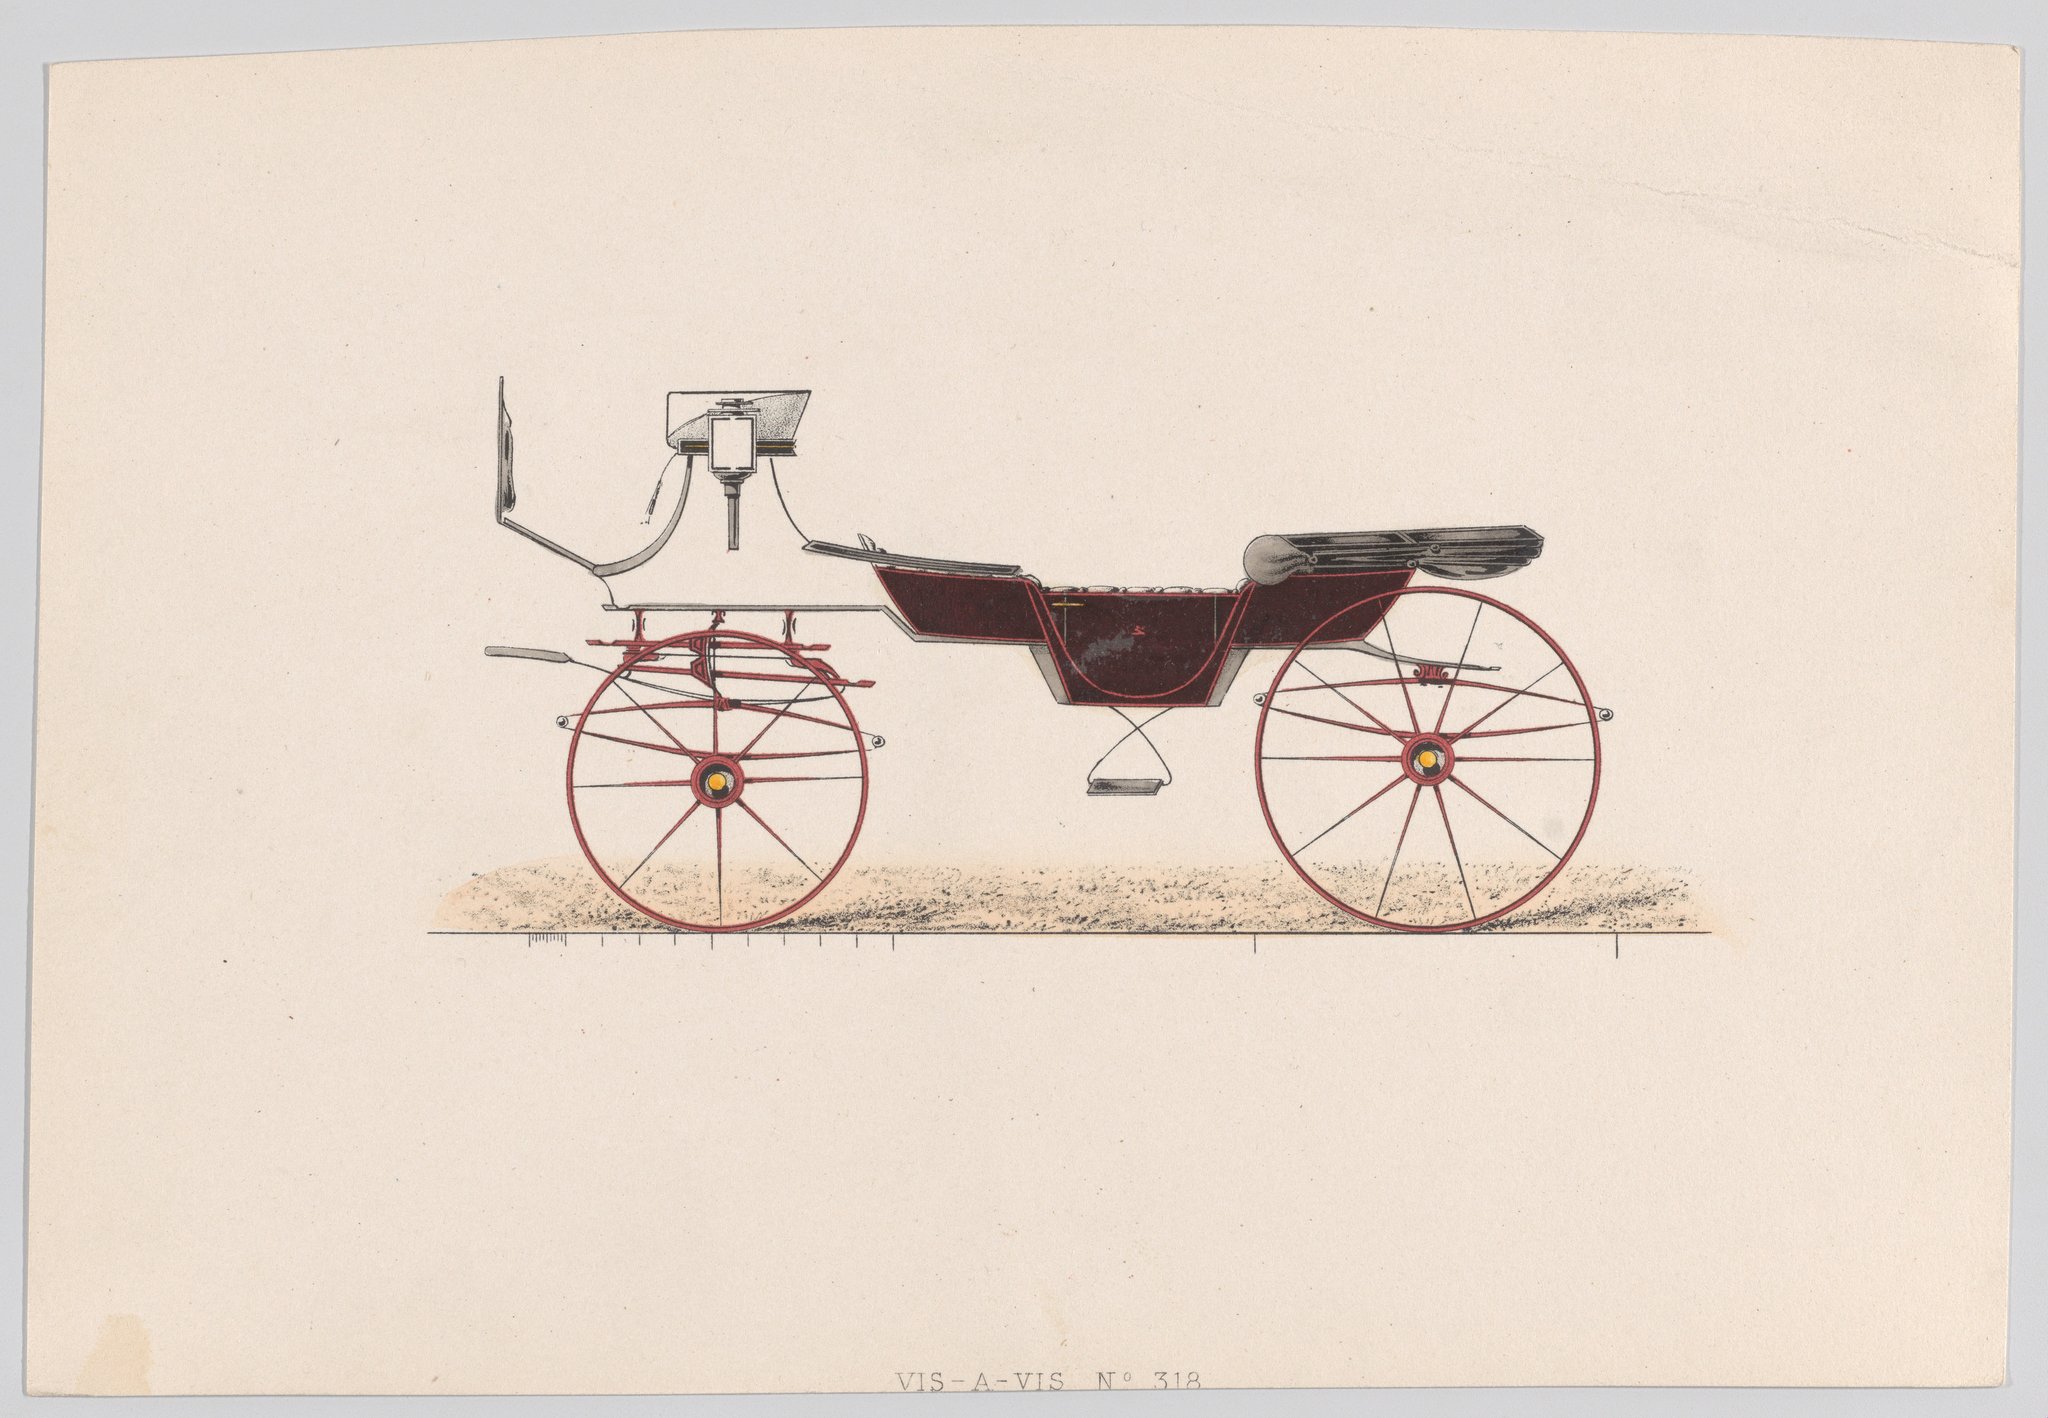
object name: print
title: Design for Vis-A-Vis Carriage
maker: anonymous, french, 19th century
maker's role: artist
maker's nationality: french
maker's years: 1800-1900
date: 1870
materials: gum arabic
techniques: hand coloring, lithograph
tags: carriages